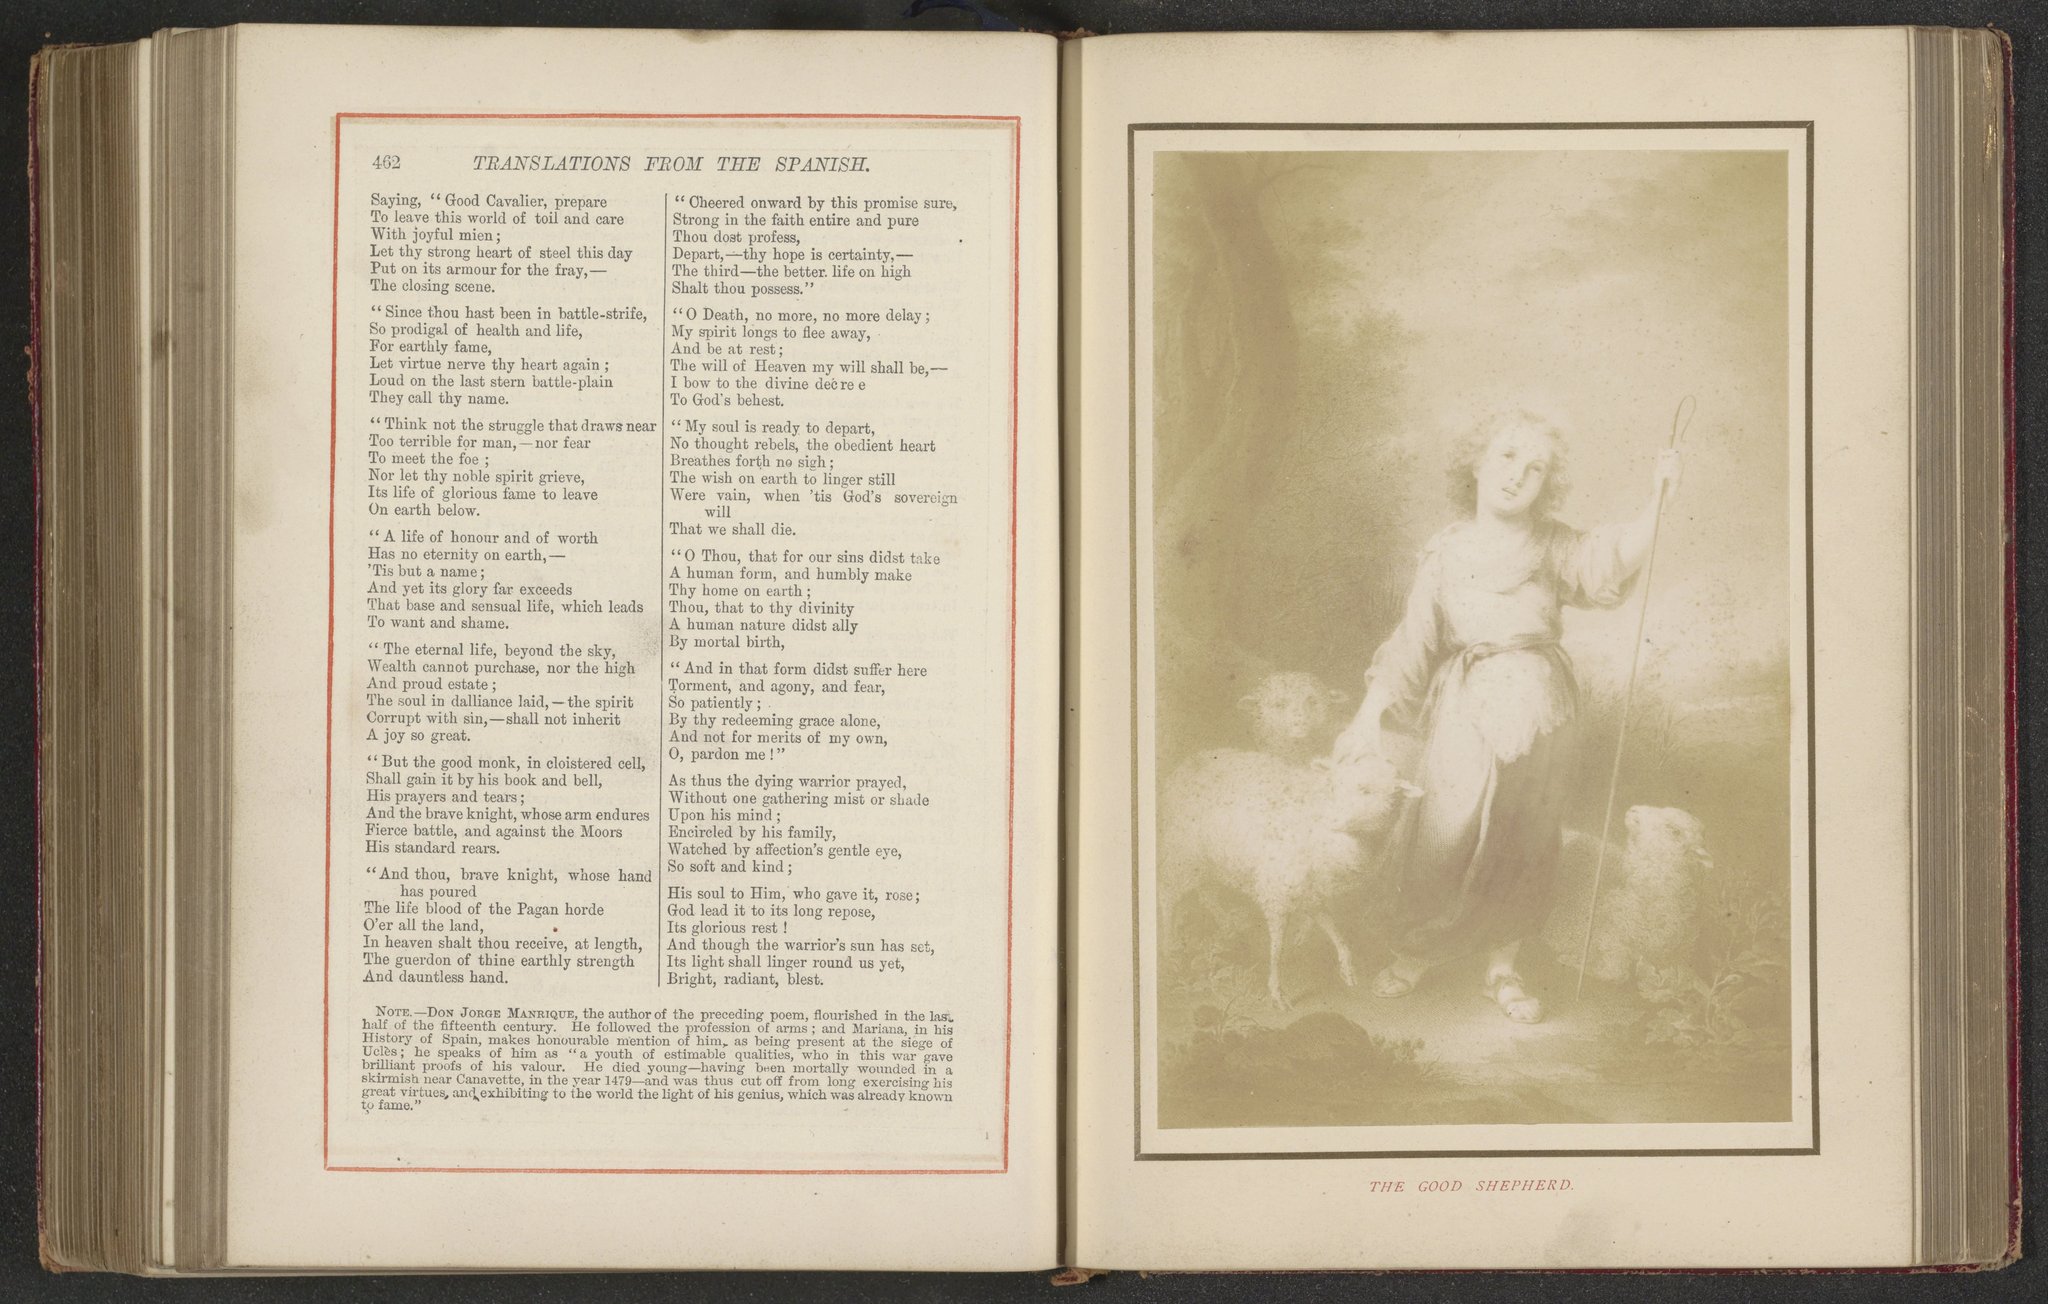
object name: photograph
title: Fotoreproductie van een afbeelding van Christus als de Goede Herder met drie schapen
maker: john payne jennings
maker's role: fotograaf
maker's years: 1843-1926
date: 1867-1877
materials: photographic support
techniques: albumen print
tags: christ as good shepherd